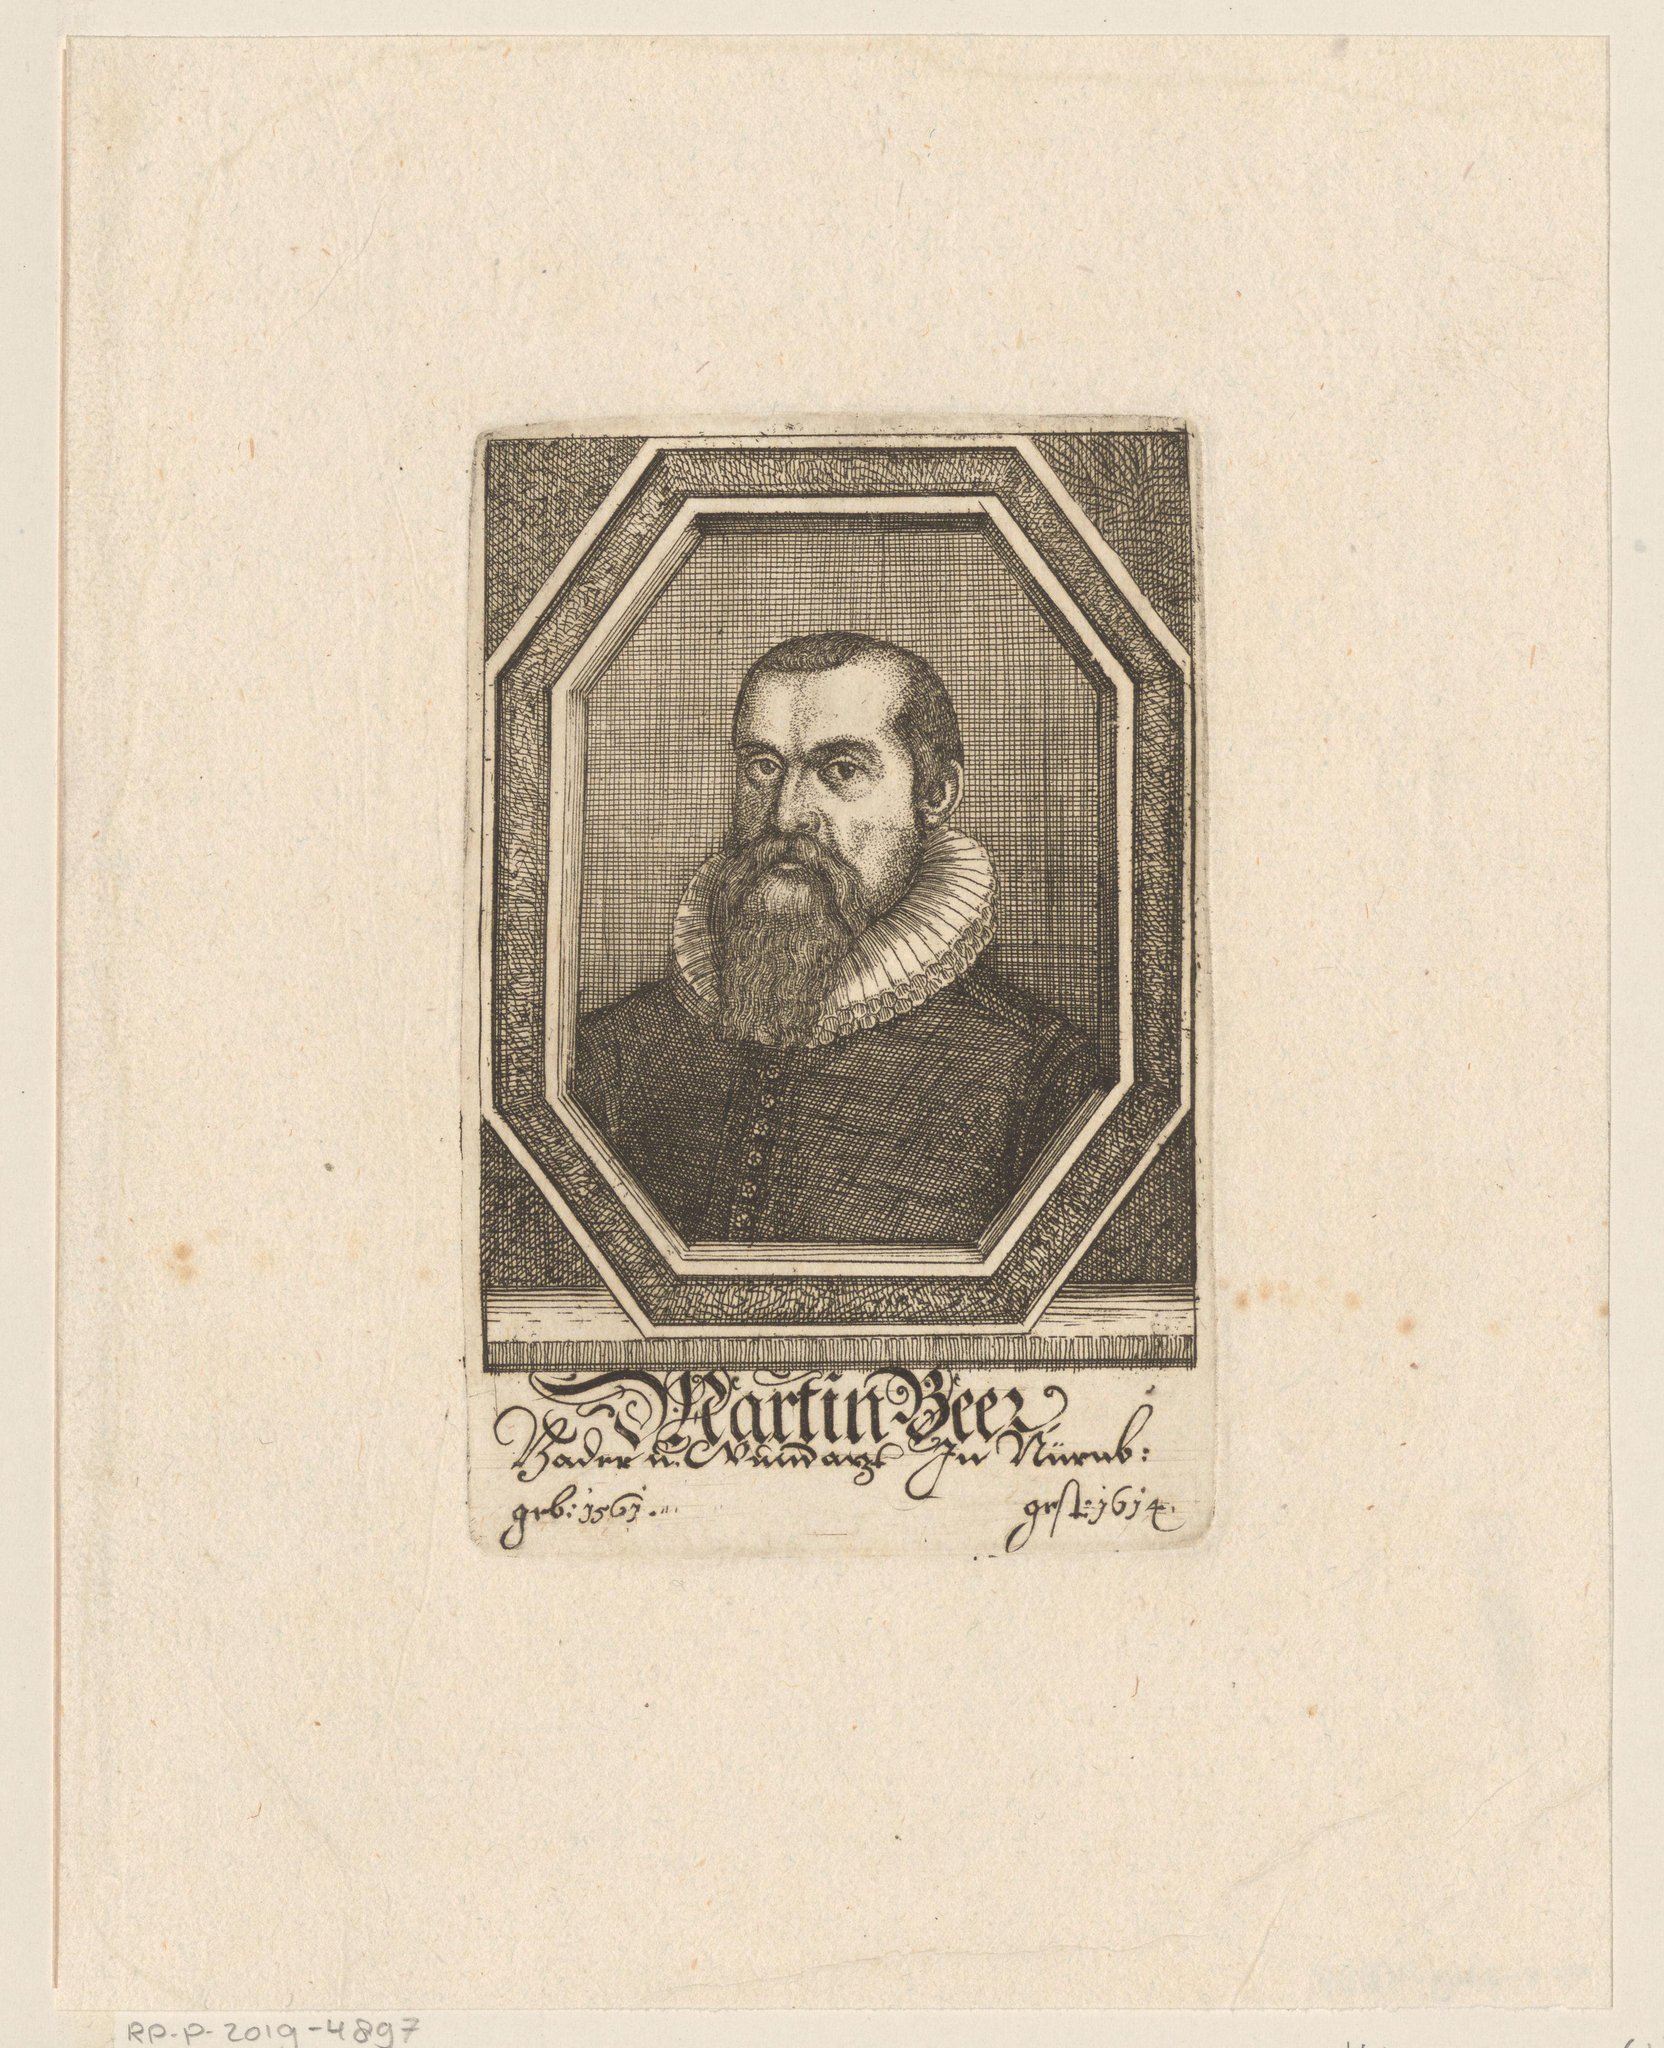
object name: print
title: Portret van Martin Beer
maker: sigmund gabriel hipschmann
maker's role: painter, print maker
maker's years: 1639-1683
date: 1649-1683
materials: paper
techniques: etching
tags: historical persons